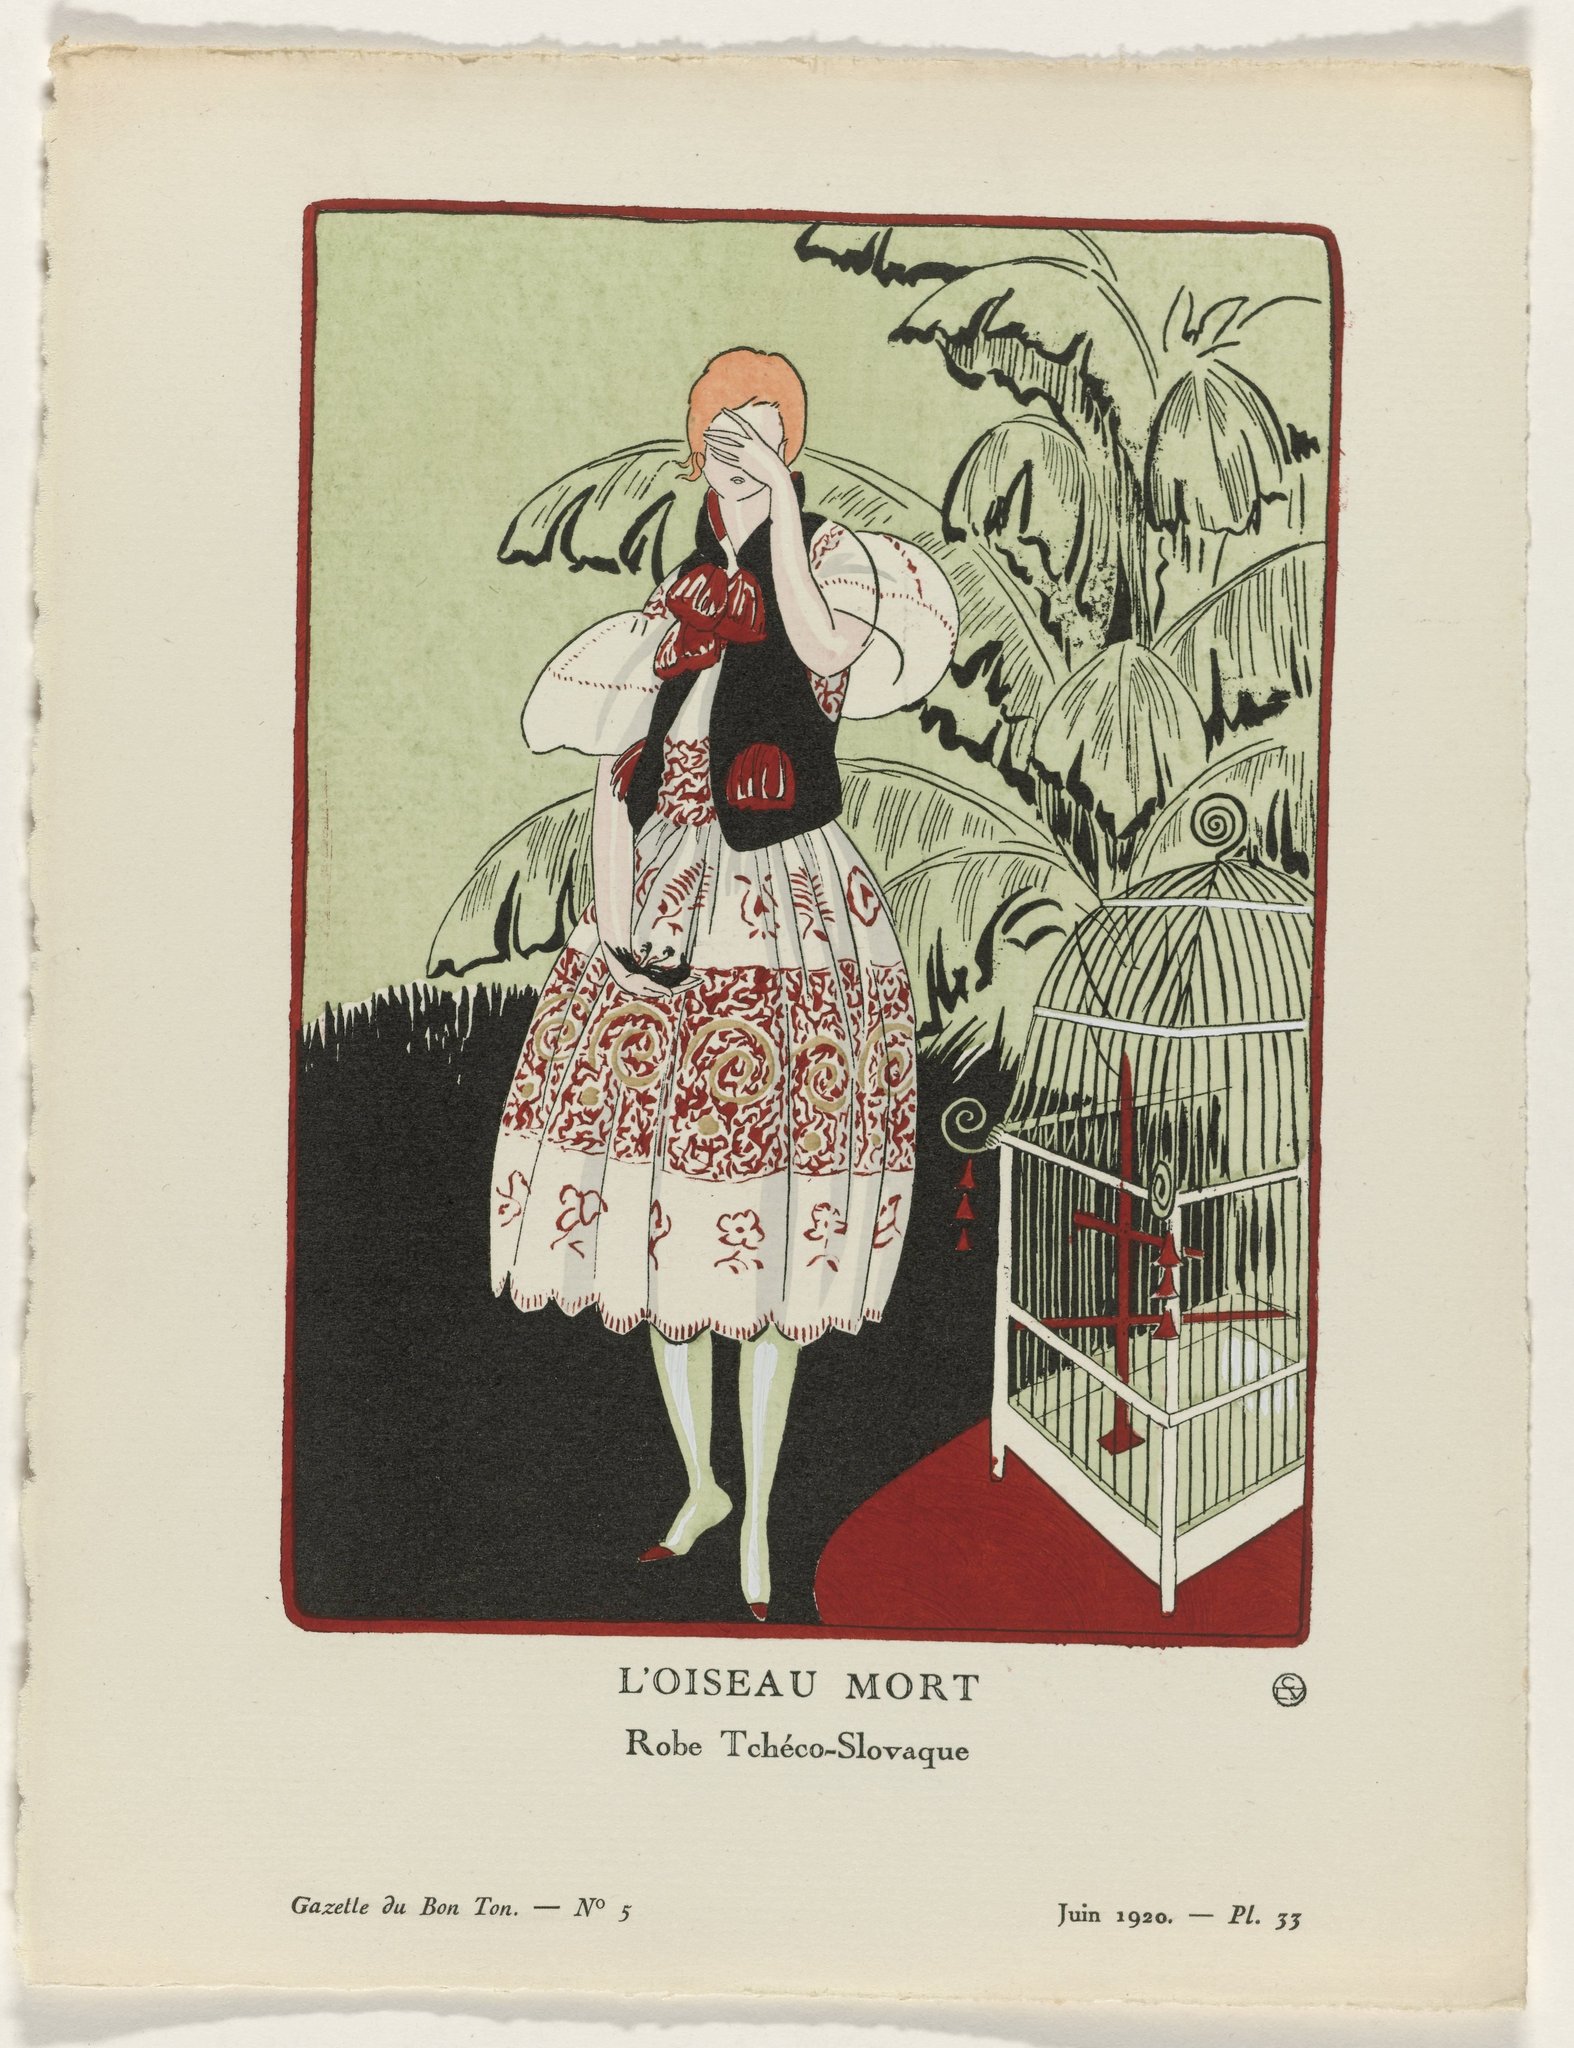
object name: fashion print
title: Gazette du Bon Ton, 1920 - No. 5, Pl. 33: L'oiseau mort / Robe Tchéco-Slovaque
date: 1920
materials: paper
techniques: hand coloring, letterpress printing, lithograph, pochoir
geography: new york city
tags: clothing for the upper part of the body (+ women's clothes), dress, gown: day dress (+ women's clothes), domestic animals, kept in and outside the house (+ dying animal; death of animal; dead animal), fashion plates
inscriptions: date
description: Staande vrouw met een dode vogel in de hand. Zij draagt een middagjapon of 'Robe Tchéco-Slovaque', met een zwart fluwelen lijfje en rode borduursels en kwasten. Planche 33 uit Gazette du Bon Ton 1920, No. 5. Uitleg over de kleding op pagina "Explication des Planches".